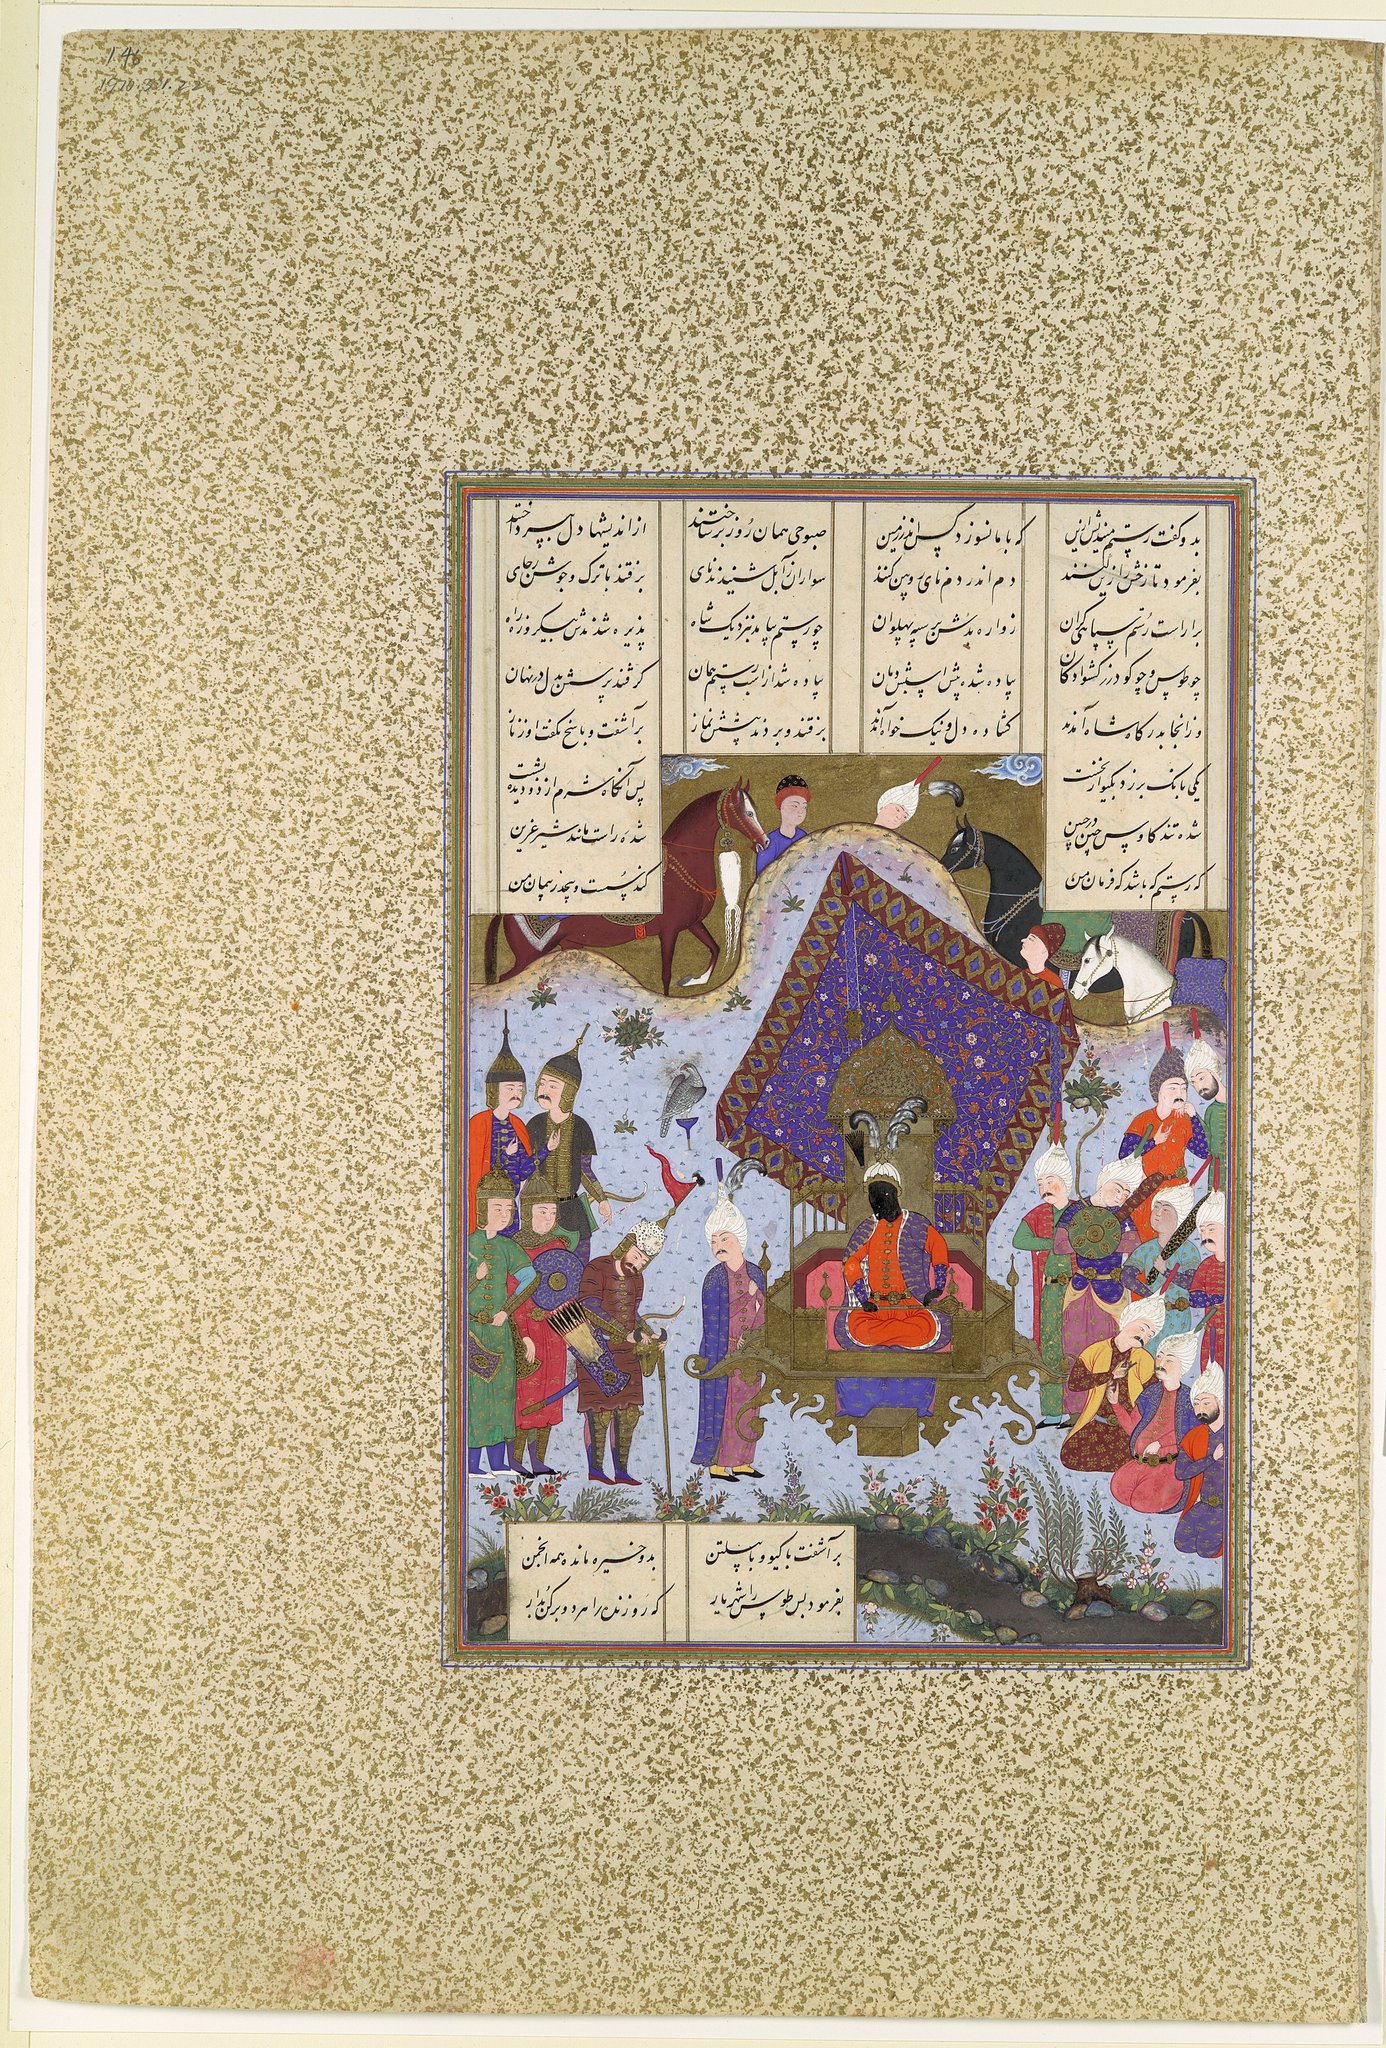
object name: folio from an illustrated manuscript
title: "Rustam Pained Before Kai Kavus", Folio 146r from the Shahnama (Book of Kings) of Shah Tahmasp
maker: abu'l qasim firdausi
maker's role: author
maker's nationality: iranian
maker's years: 935-1020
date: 1525-1530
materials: gold, ink, paper, silver, watercolor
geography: iran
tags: soldiers,men